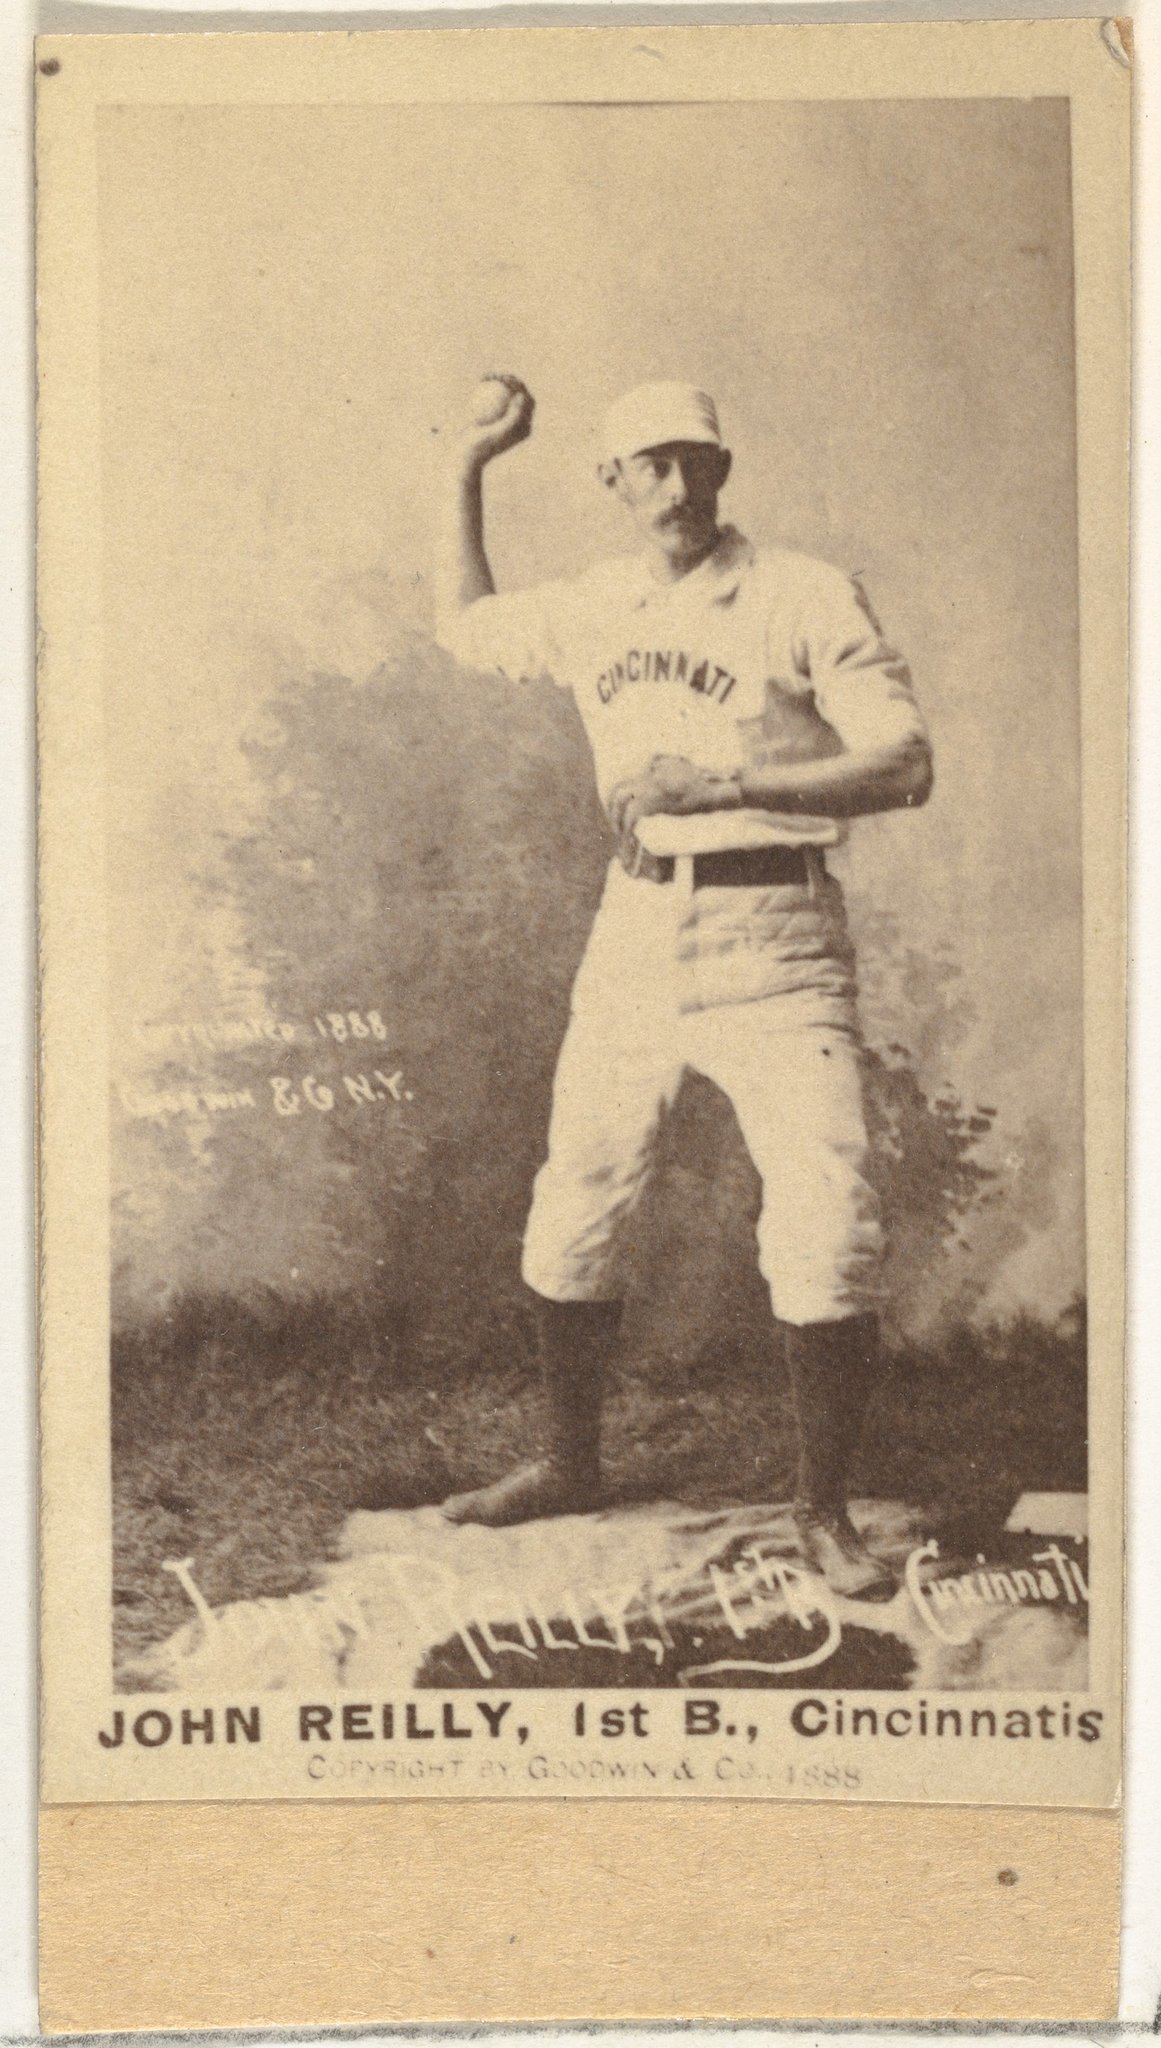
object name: baseball card, photograph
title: John Good "Long John" Reilly, 1st Base, Cincinnati, from the Old Judge series (N172) for Old Judge Cigarettes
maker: goodwin & company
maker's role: publisher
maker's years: 1850-1950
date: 1888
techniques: albumen silver print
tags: men,portraits,baseball,athletes